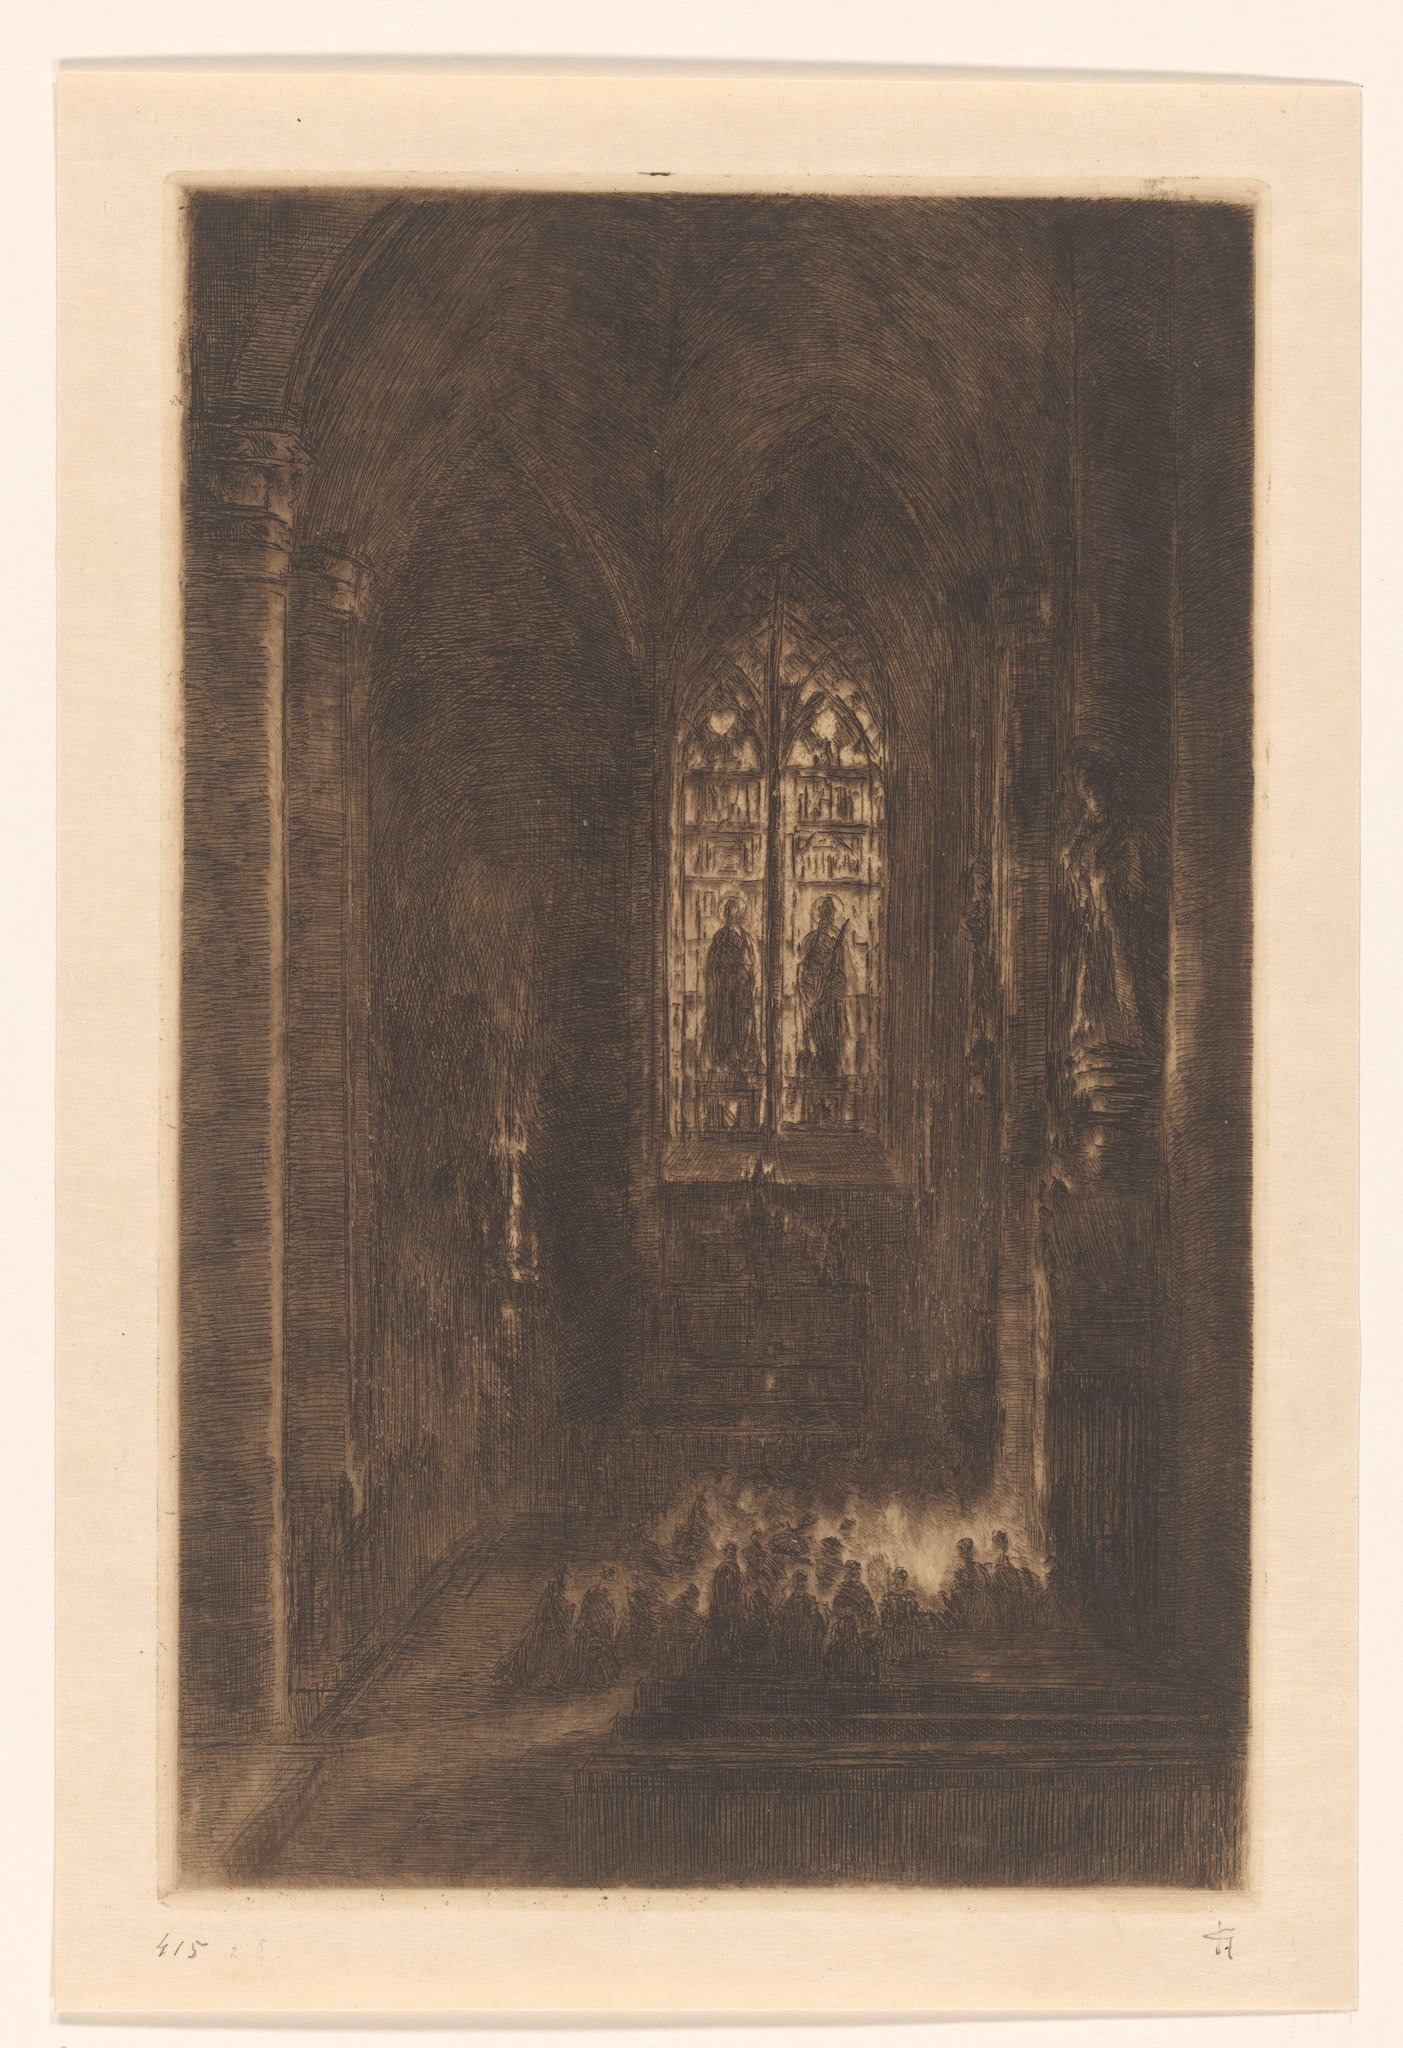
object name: print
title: Kerkinterieur in Kleef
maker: carel nicolaas storm van s-gravesande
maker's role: draughtsman, print maker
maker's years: 1841-1924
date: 1851-1902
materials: paper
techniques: etching, intaglio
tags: interior of church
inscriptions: number: ‘415’, collector's mark: Lugt 2228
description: Mogelijk vermeld in: Storm van 's-Gravesande, Charles. Catalogue des eaux-fortes et lithographies. New York: s.n., 1903, of in een onbekende latere uitgave van het manuscript. Vermoedelijk vermeld als catalogusnummer 415.